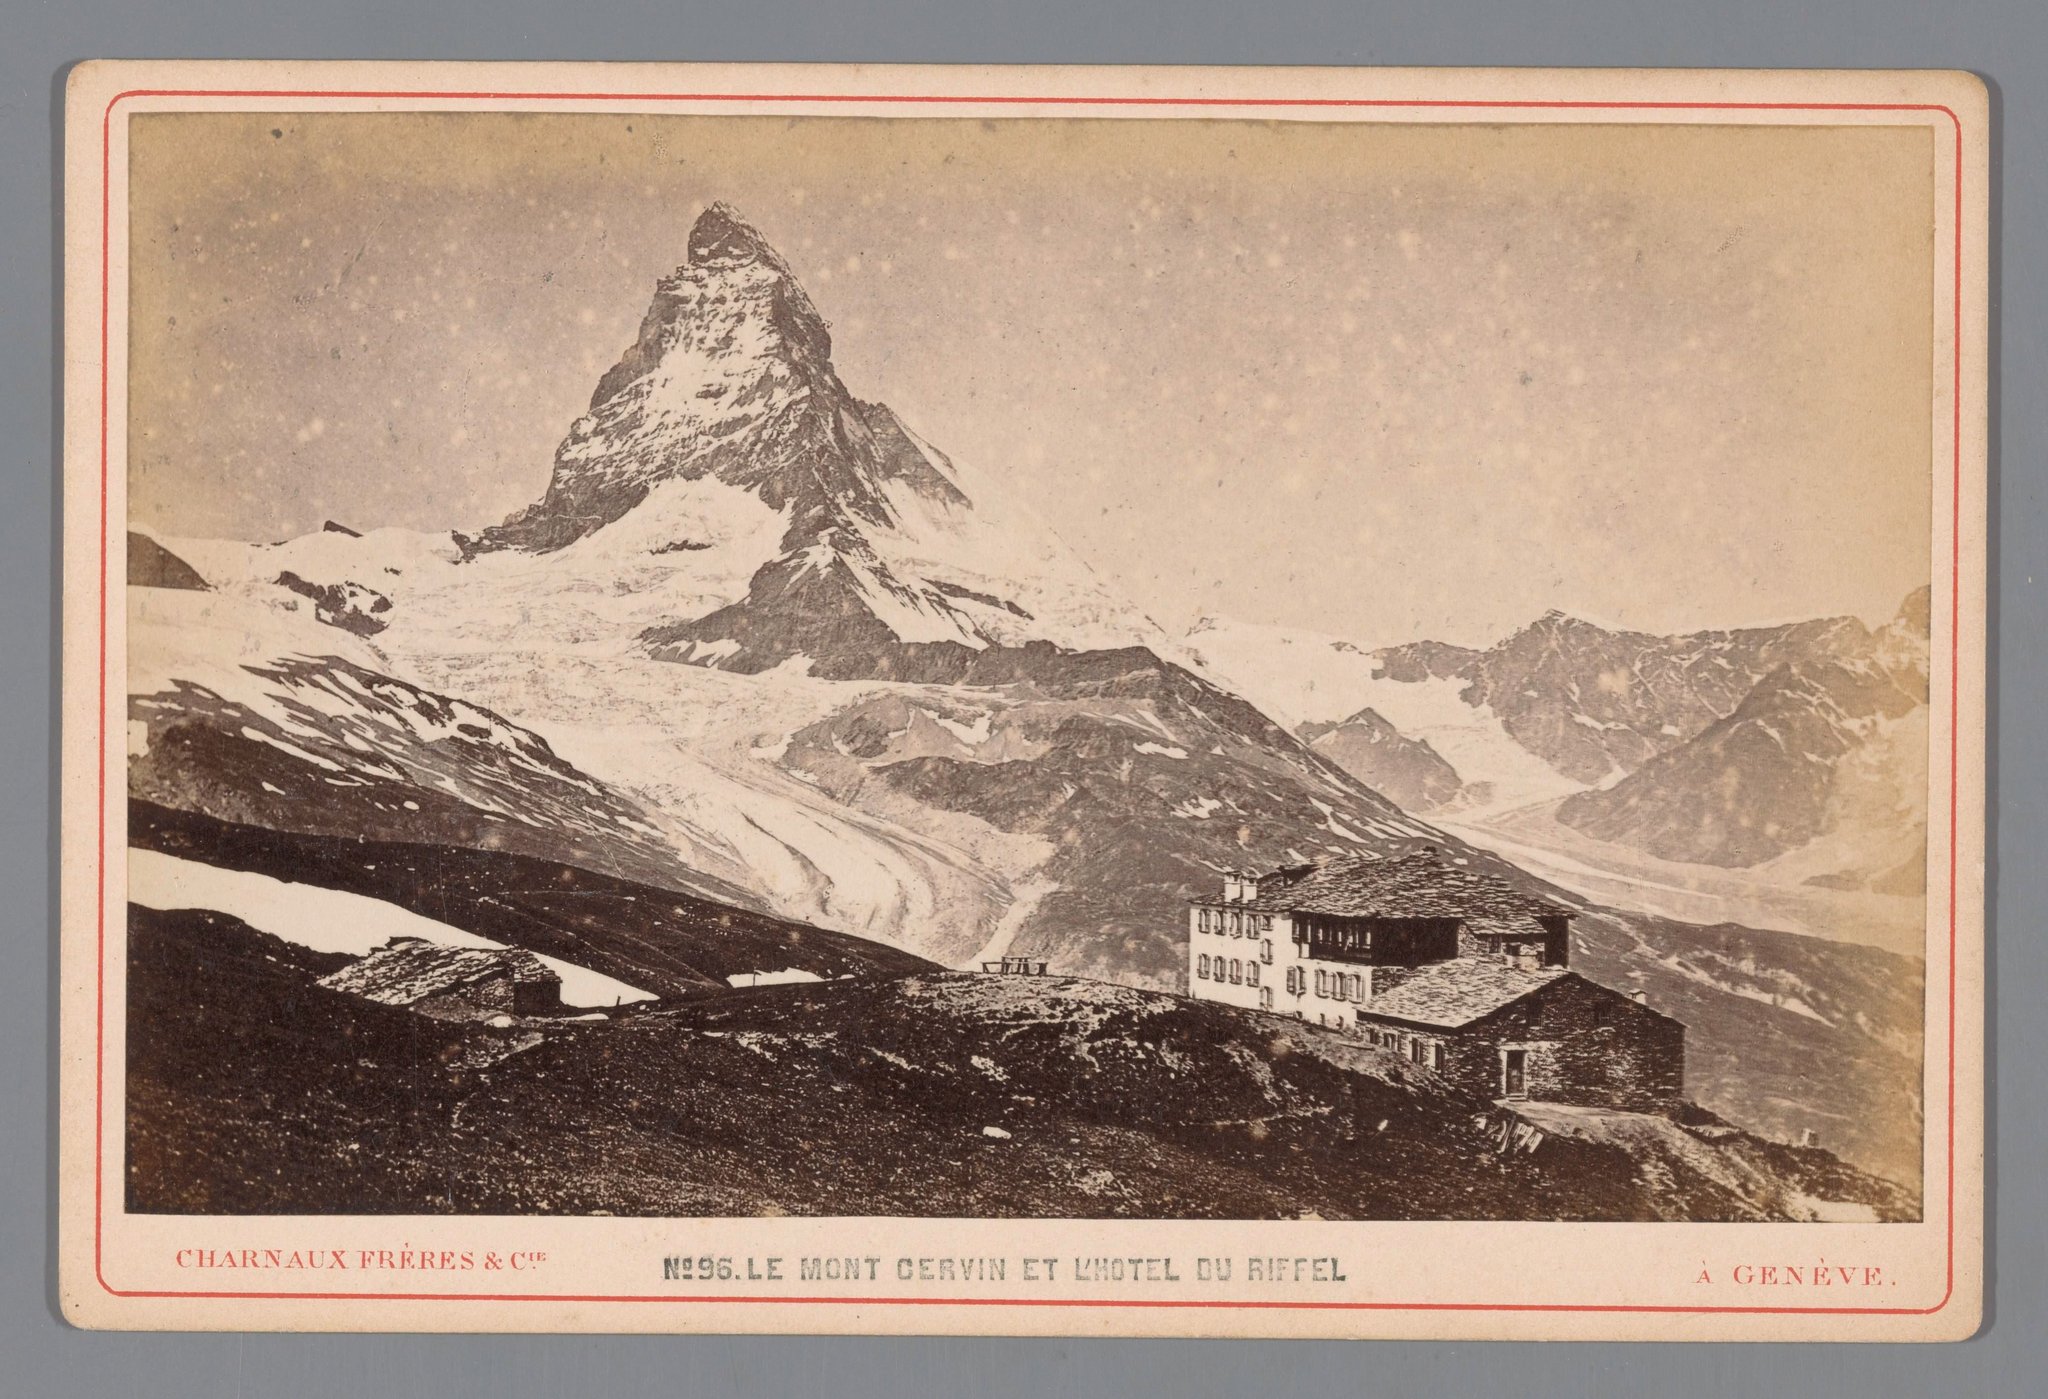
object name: photograph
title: Gezicht op de Matterhorn en Hotel du Riffel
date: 1883-1885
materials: cardboard, photographic support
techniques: albumen print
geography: switzerland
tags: mountain-range, snow peaks, hotel, hostelry, inn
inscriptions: number: ‘No. 96.’